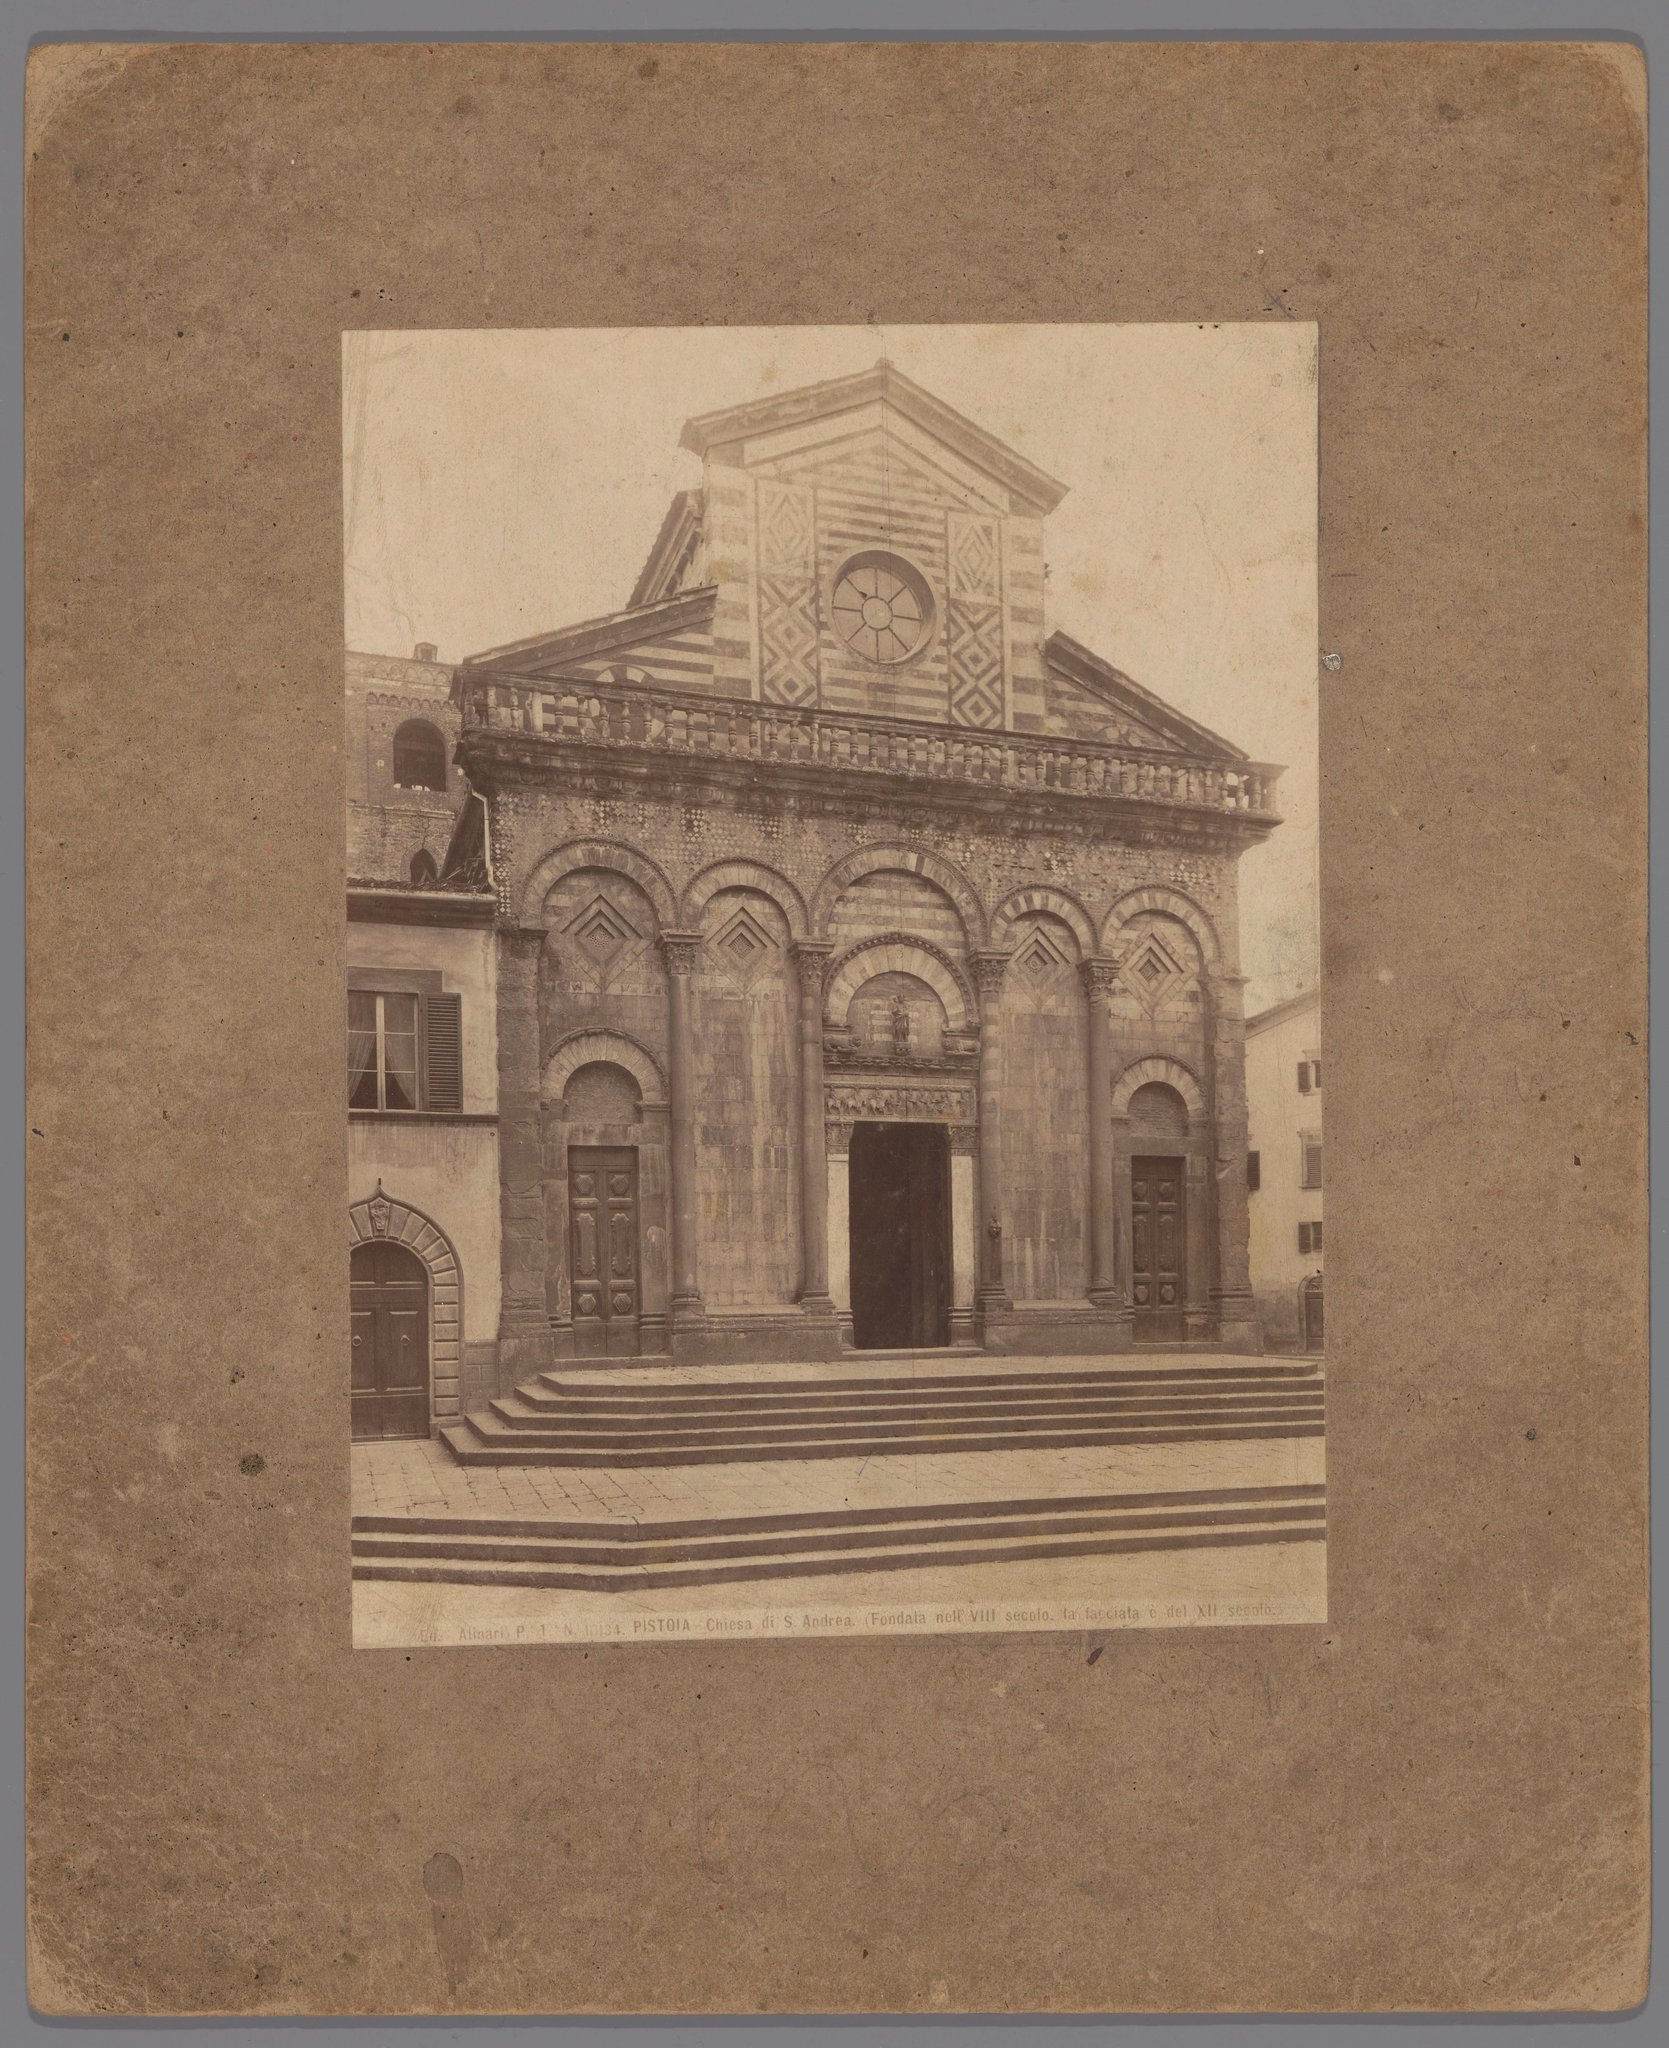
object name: photograph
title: PISTOIA - Chiesa di S. Andrea.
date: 1875-1900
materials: cardboard, photographic support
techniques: albumen print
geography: pistoia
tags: church (exterior), façade (of house or building)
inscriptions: collector's mark: Lugt 3937, number: ‘P.e 2.a N.o 10134.’